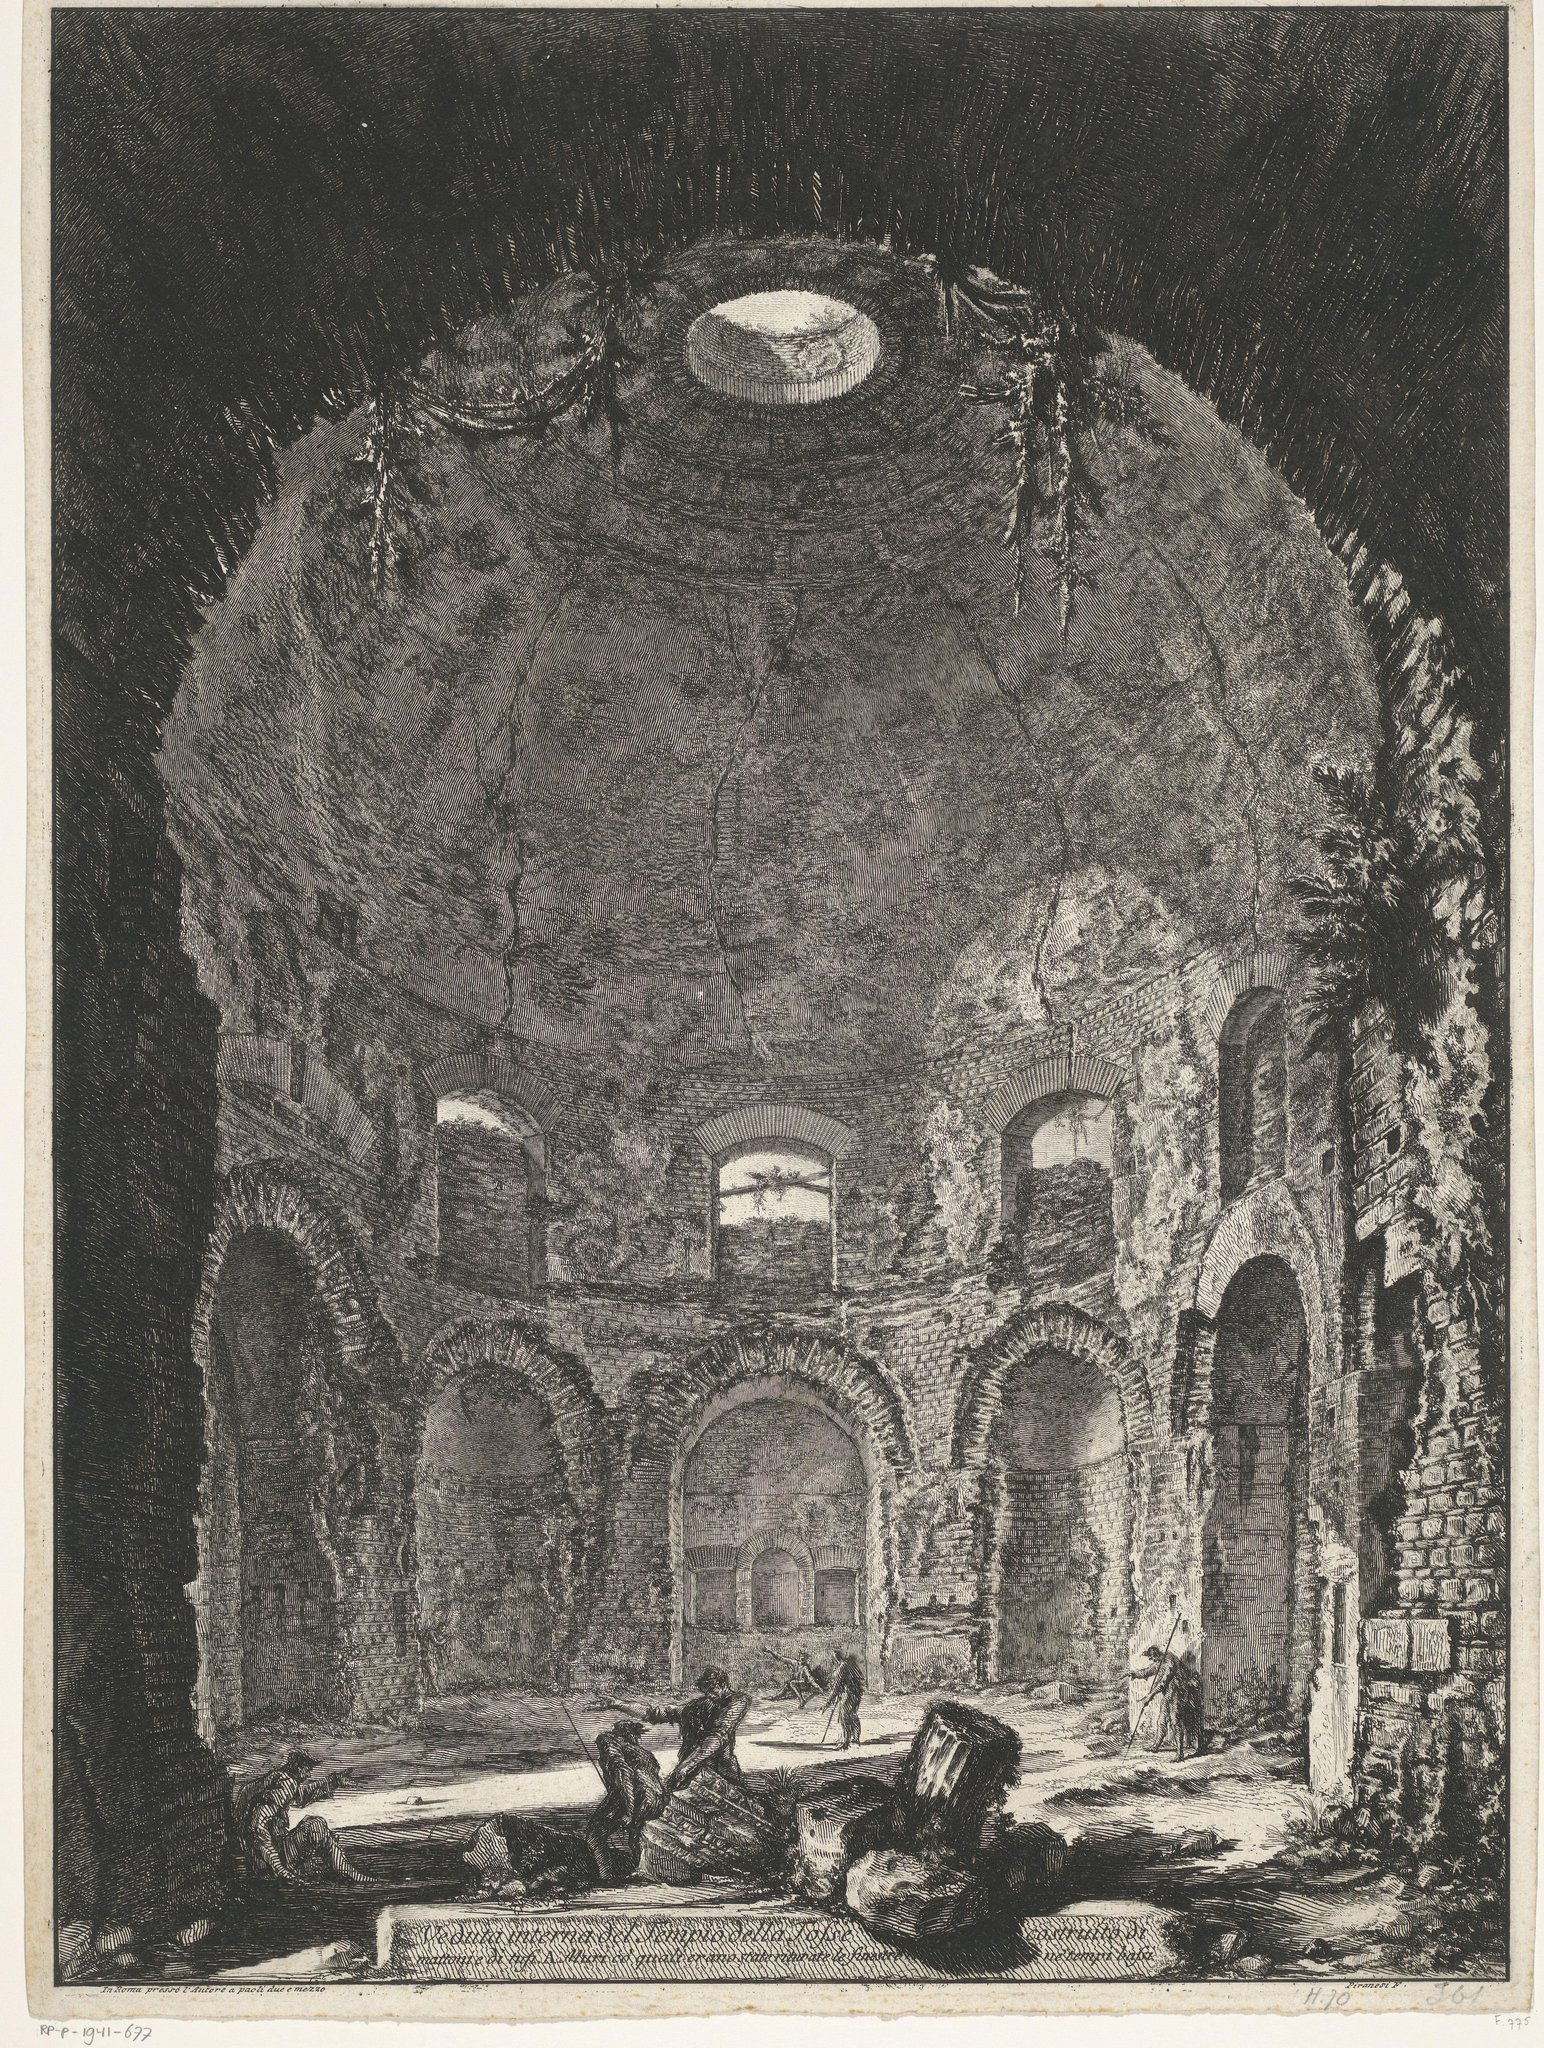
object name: print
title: Interieur van de Tempio della Tosse bij Tivoli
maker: giovanni battista piranesi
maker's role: designer, draughtsman, print maker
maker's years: 1720-1778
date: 1748-1778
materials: paper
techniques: etching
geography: rome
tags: ruin of a building ~ architecture, landscape with ruins, temple, shrine ~ roman religion, tivoli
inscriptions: collector's mark: Lugt 2228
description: Deze prent maakt deel uit van de serie 'Vedute di Roma'. Piranesi werkte aan deze 135 platen tellende serie tussen 1748 en zijn dood in 1778. Francesco Piranesi voegde later nog twee prenten toe aan de reeks van zijn vader.